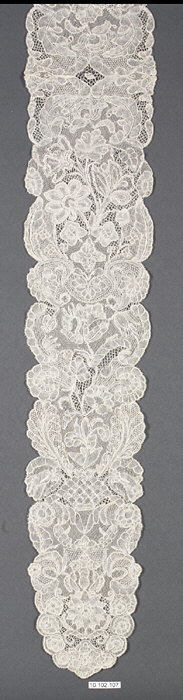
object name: barbe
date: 1701-1733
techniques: lace